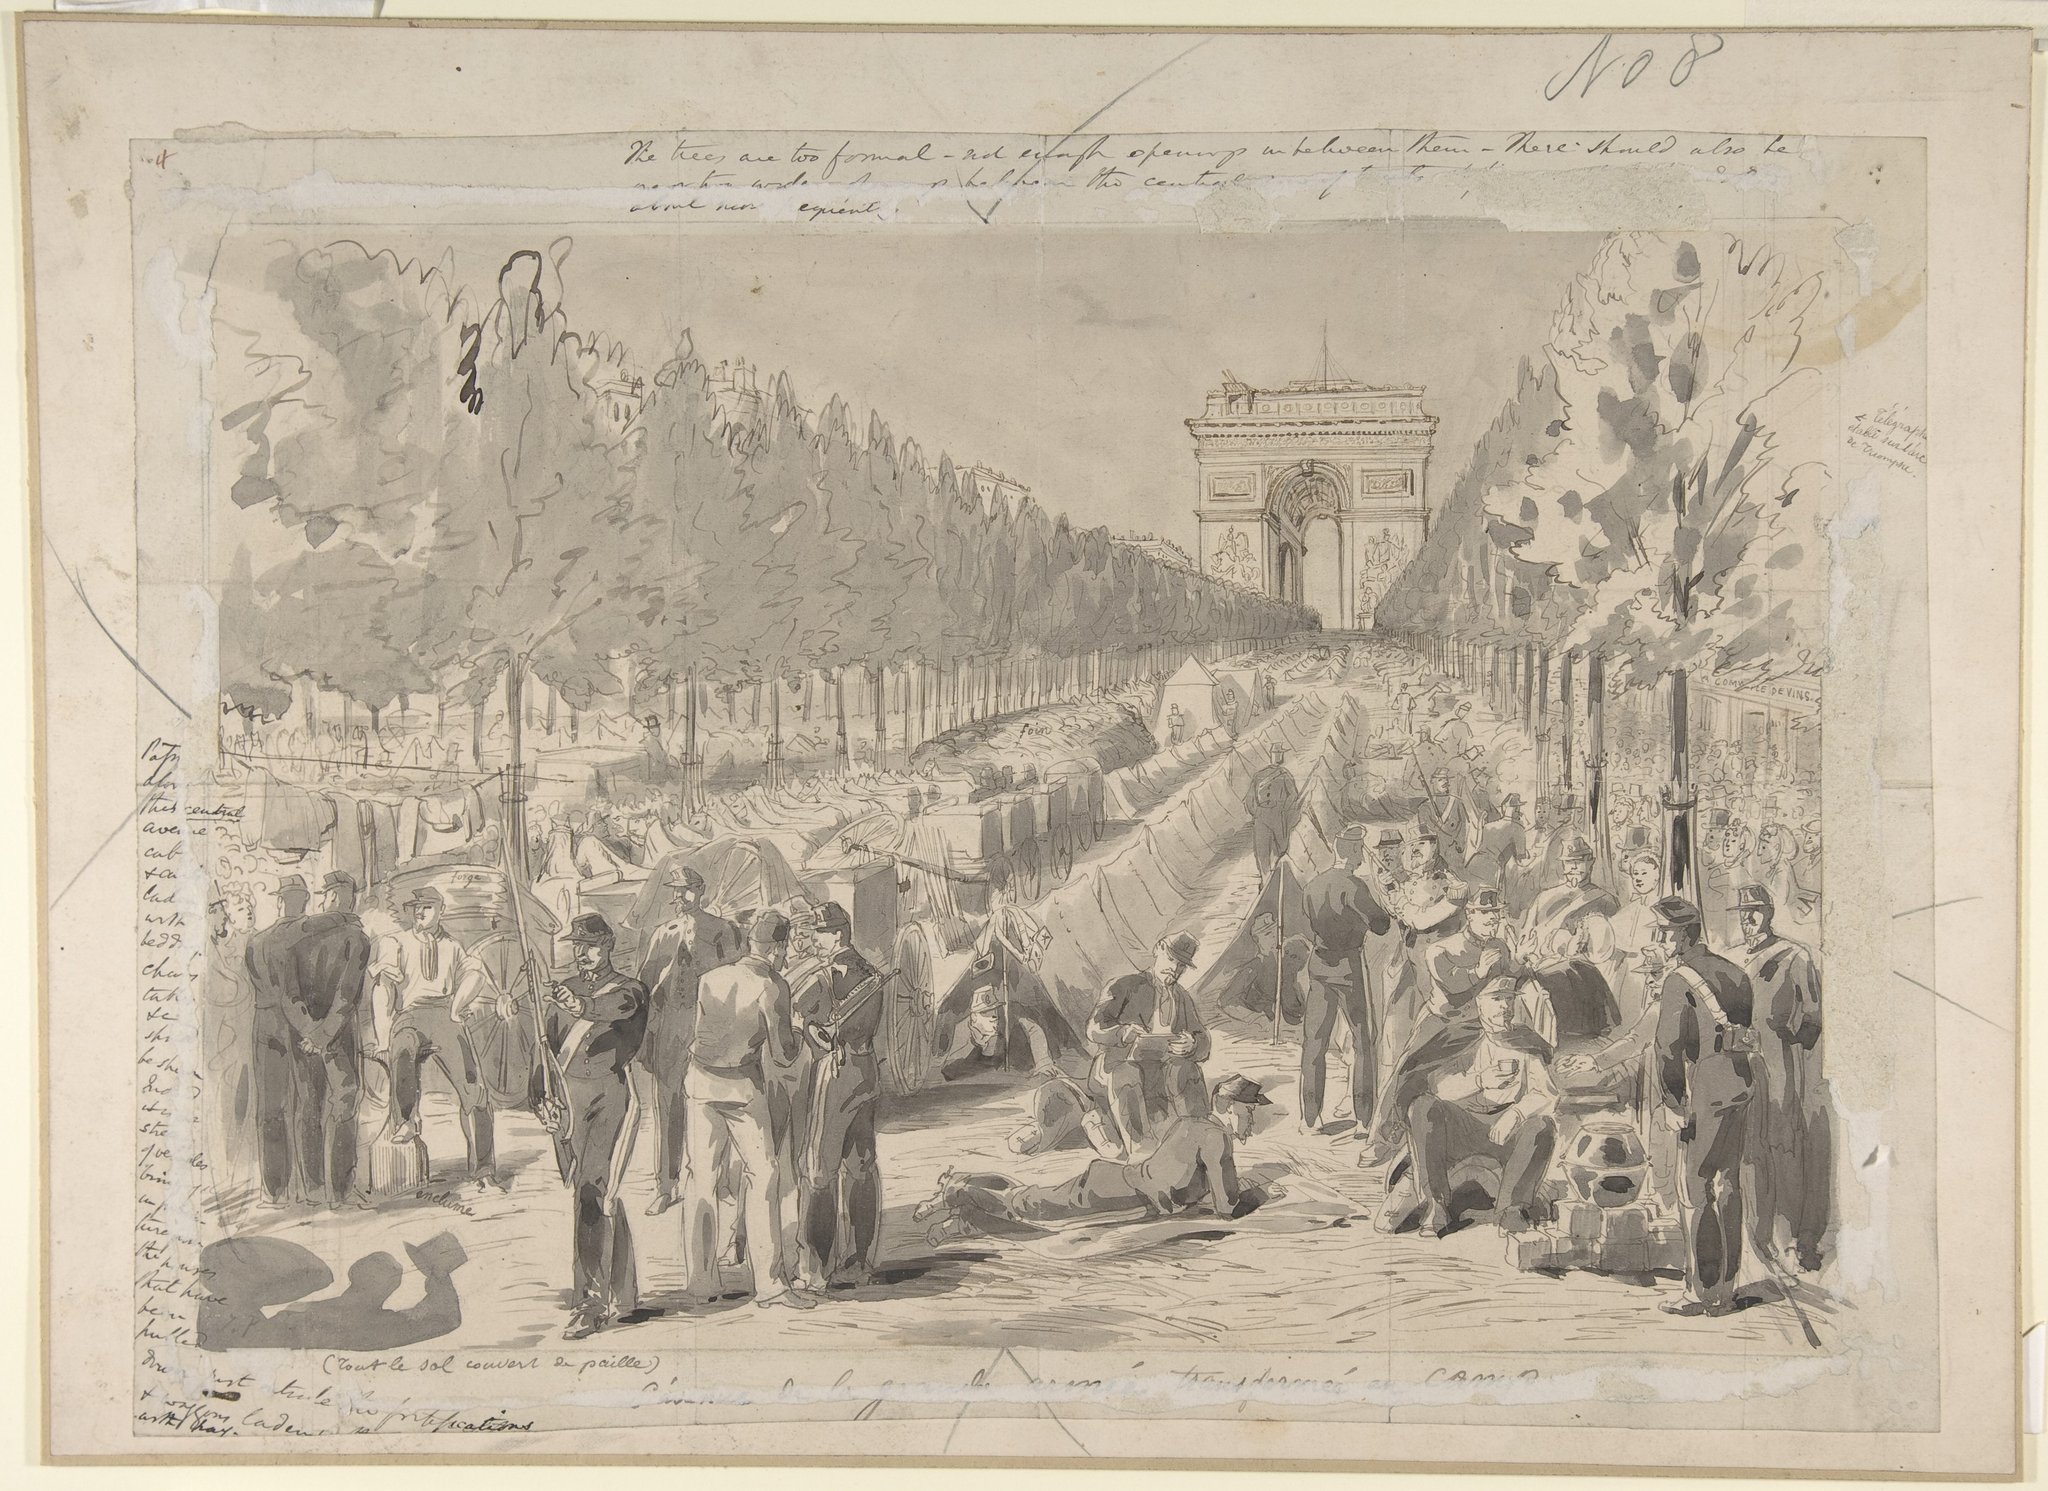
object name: drawing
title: Troops Encamped on the Champs Elysées, 1870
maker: anonymous, french, 19th century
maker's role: artist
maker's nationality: french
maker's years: 1800-1900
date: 1801-1900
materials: ink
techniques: brush, pen, wash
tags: gates,tents,soldiers,men,trees